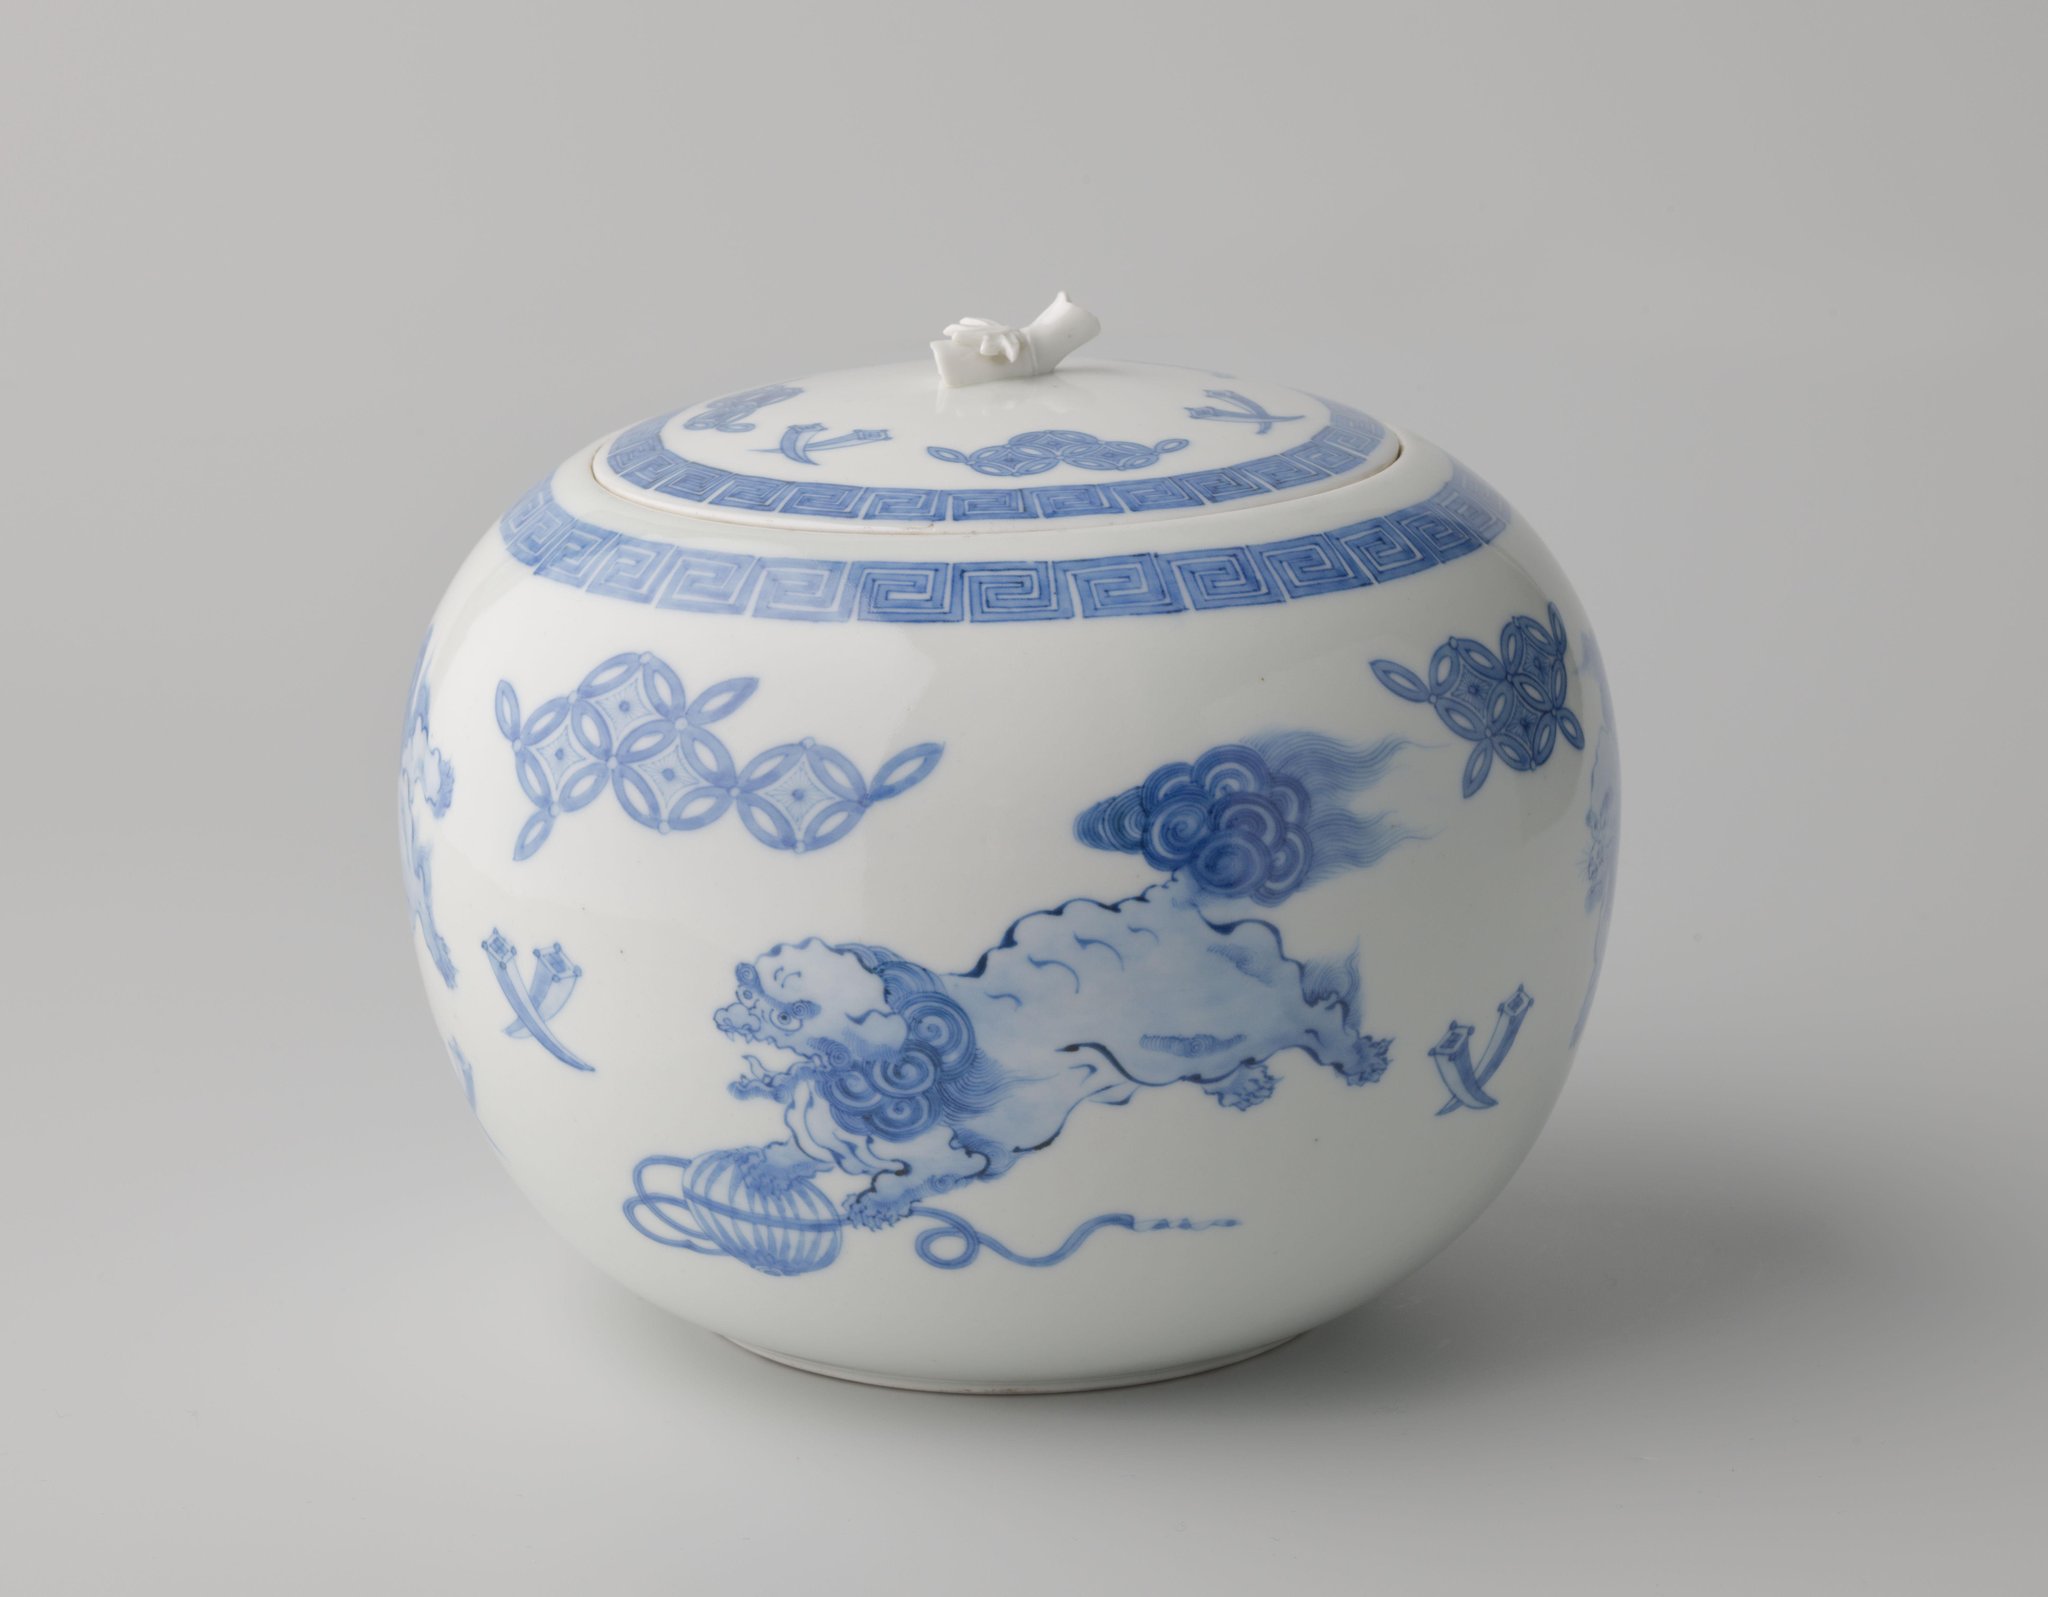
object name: covered jar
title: Round covered jar with shishi and auspicious symbols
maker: Anonymous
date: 1750-1849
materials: cobalt, glaze, paint, porcelain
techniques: firing, turning, vitrification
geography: hirado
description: Deksel van ronde dekselpot van porselein, beschilderd in onderglazuur blauw. Op de deksel gelukssymbolen (horens, munten). Langs de rand een band met meanderpatroon. Dekselknop in de vorm van een bamboetak. Blauw-wit Hirado.